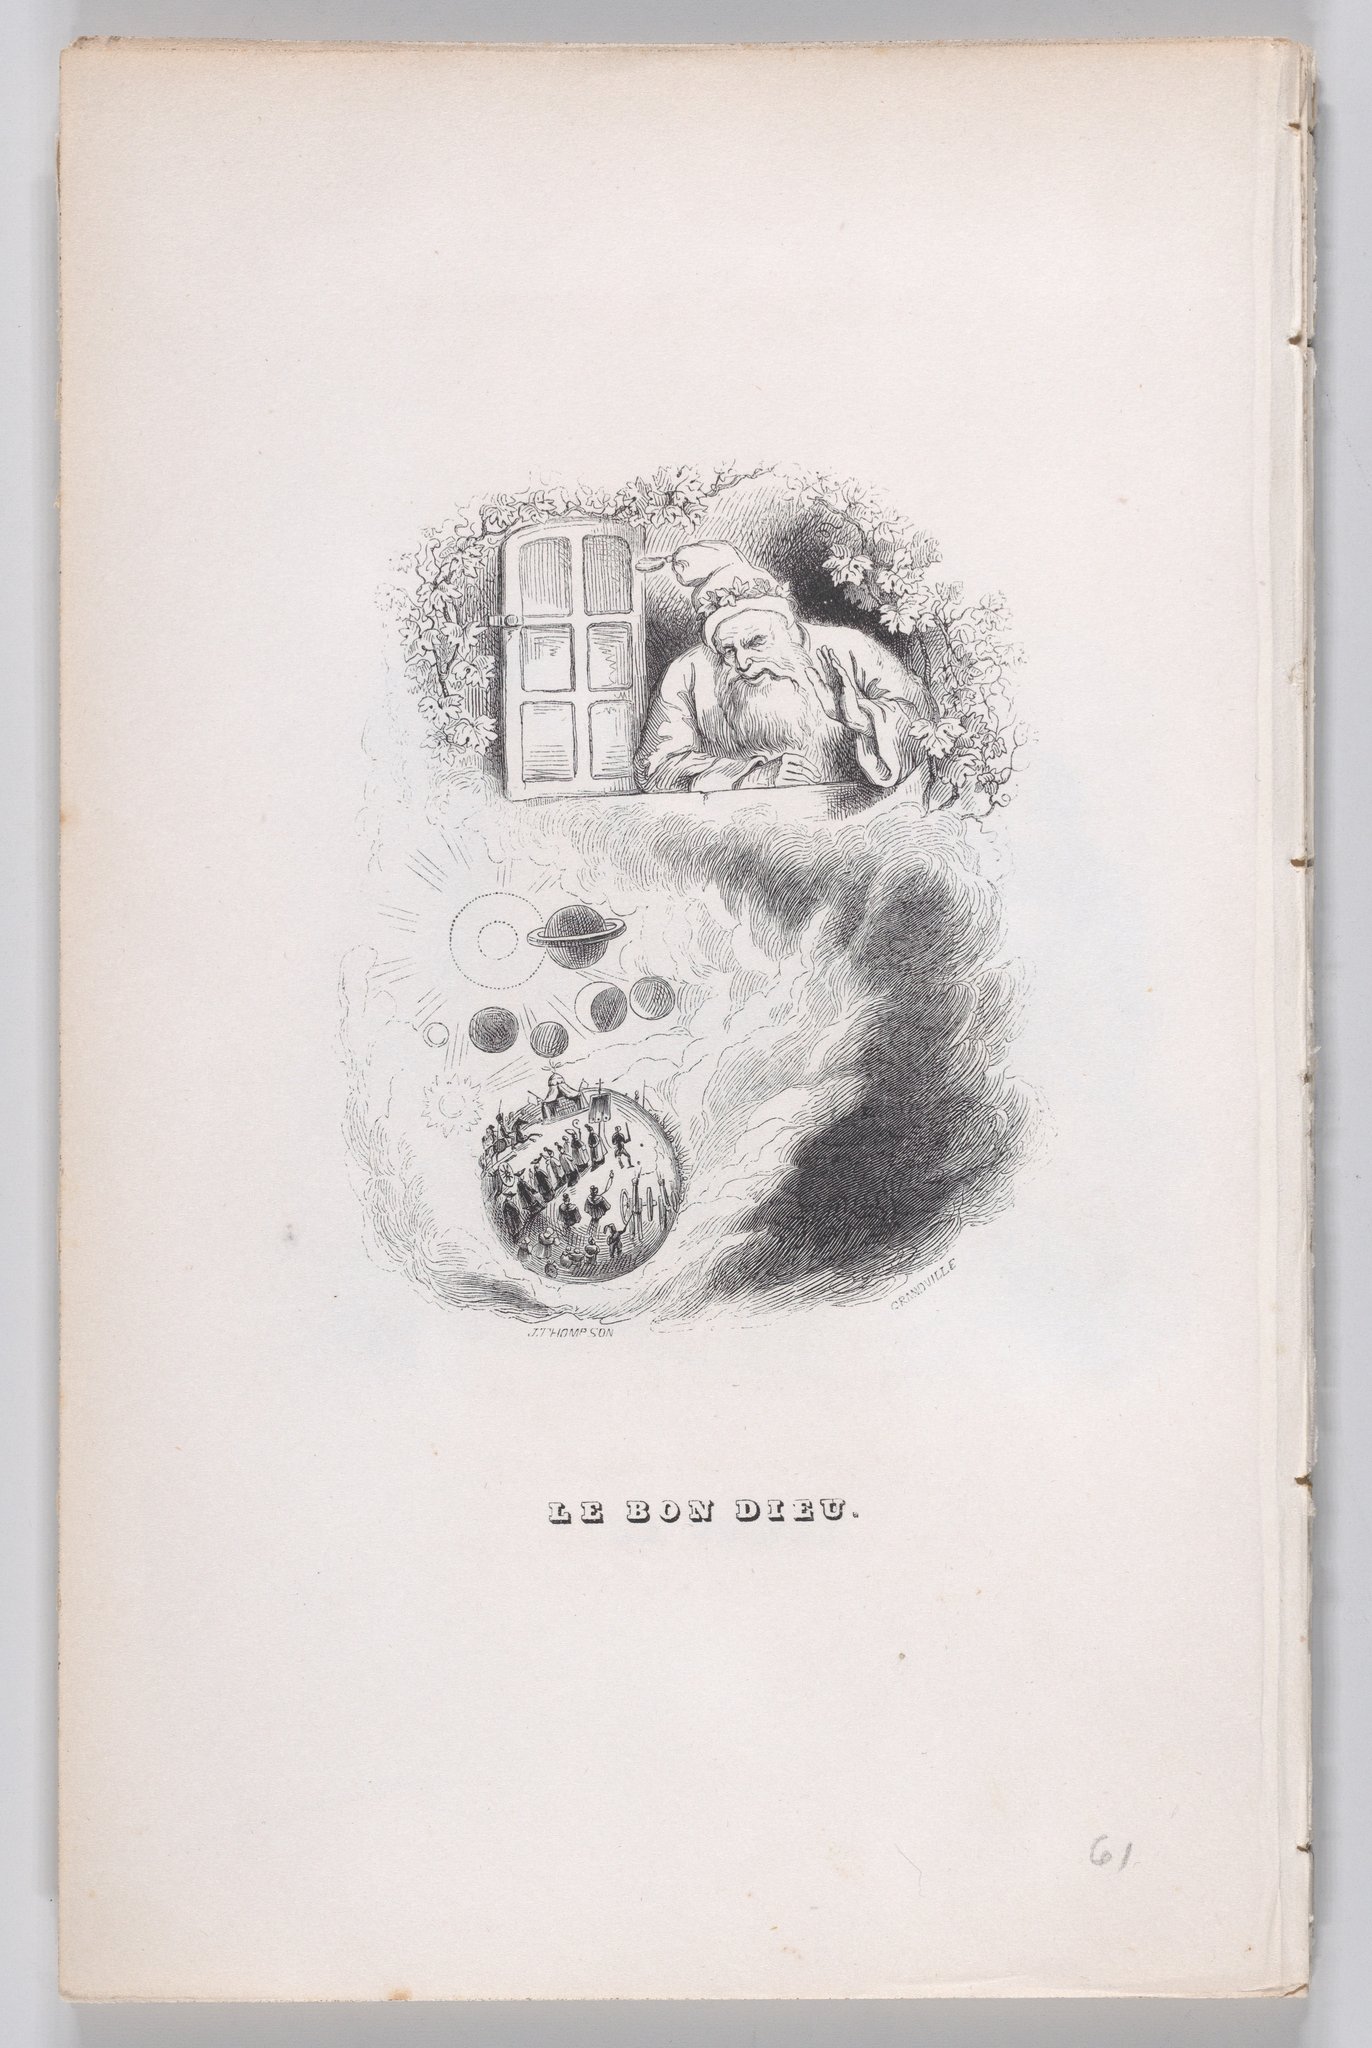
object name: print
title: The Good God, from "The Complete Works of Béranger"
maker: j. j. grandville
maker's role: illustrator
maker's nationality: french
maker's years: 1803-1847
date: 1836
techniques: engraving